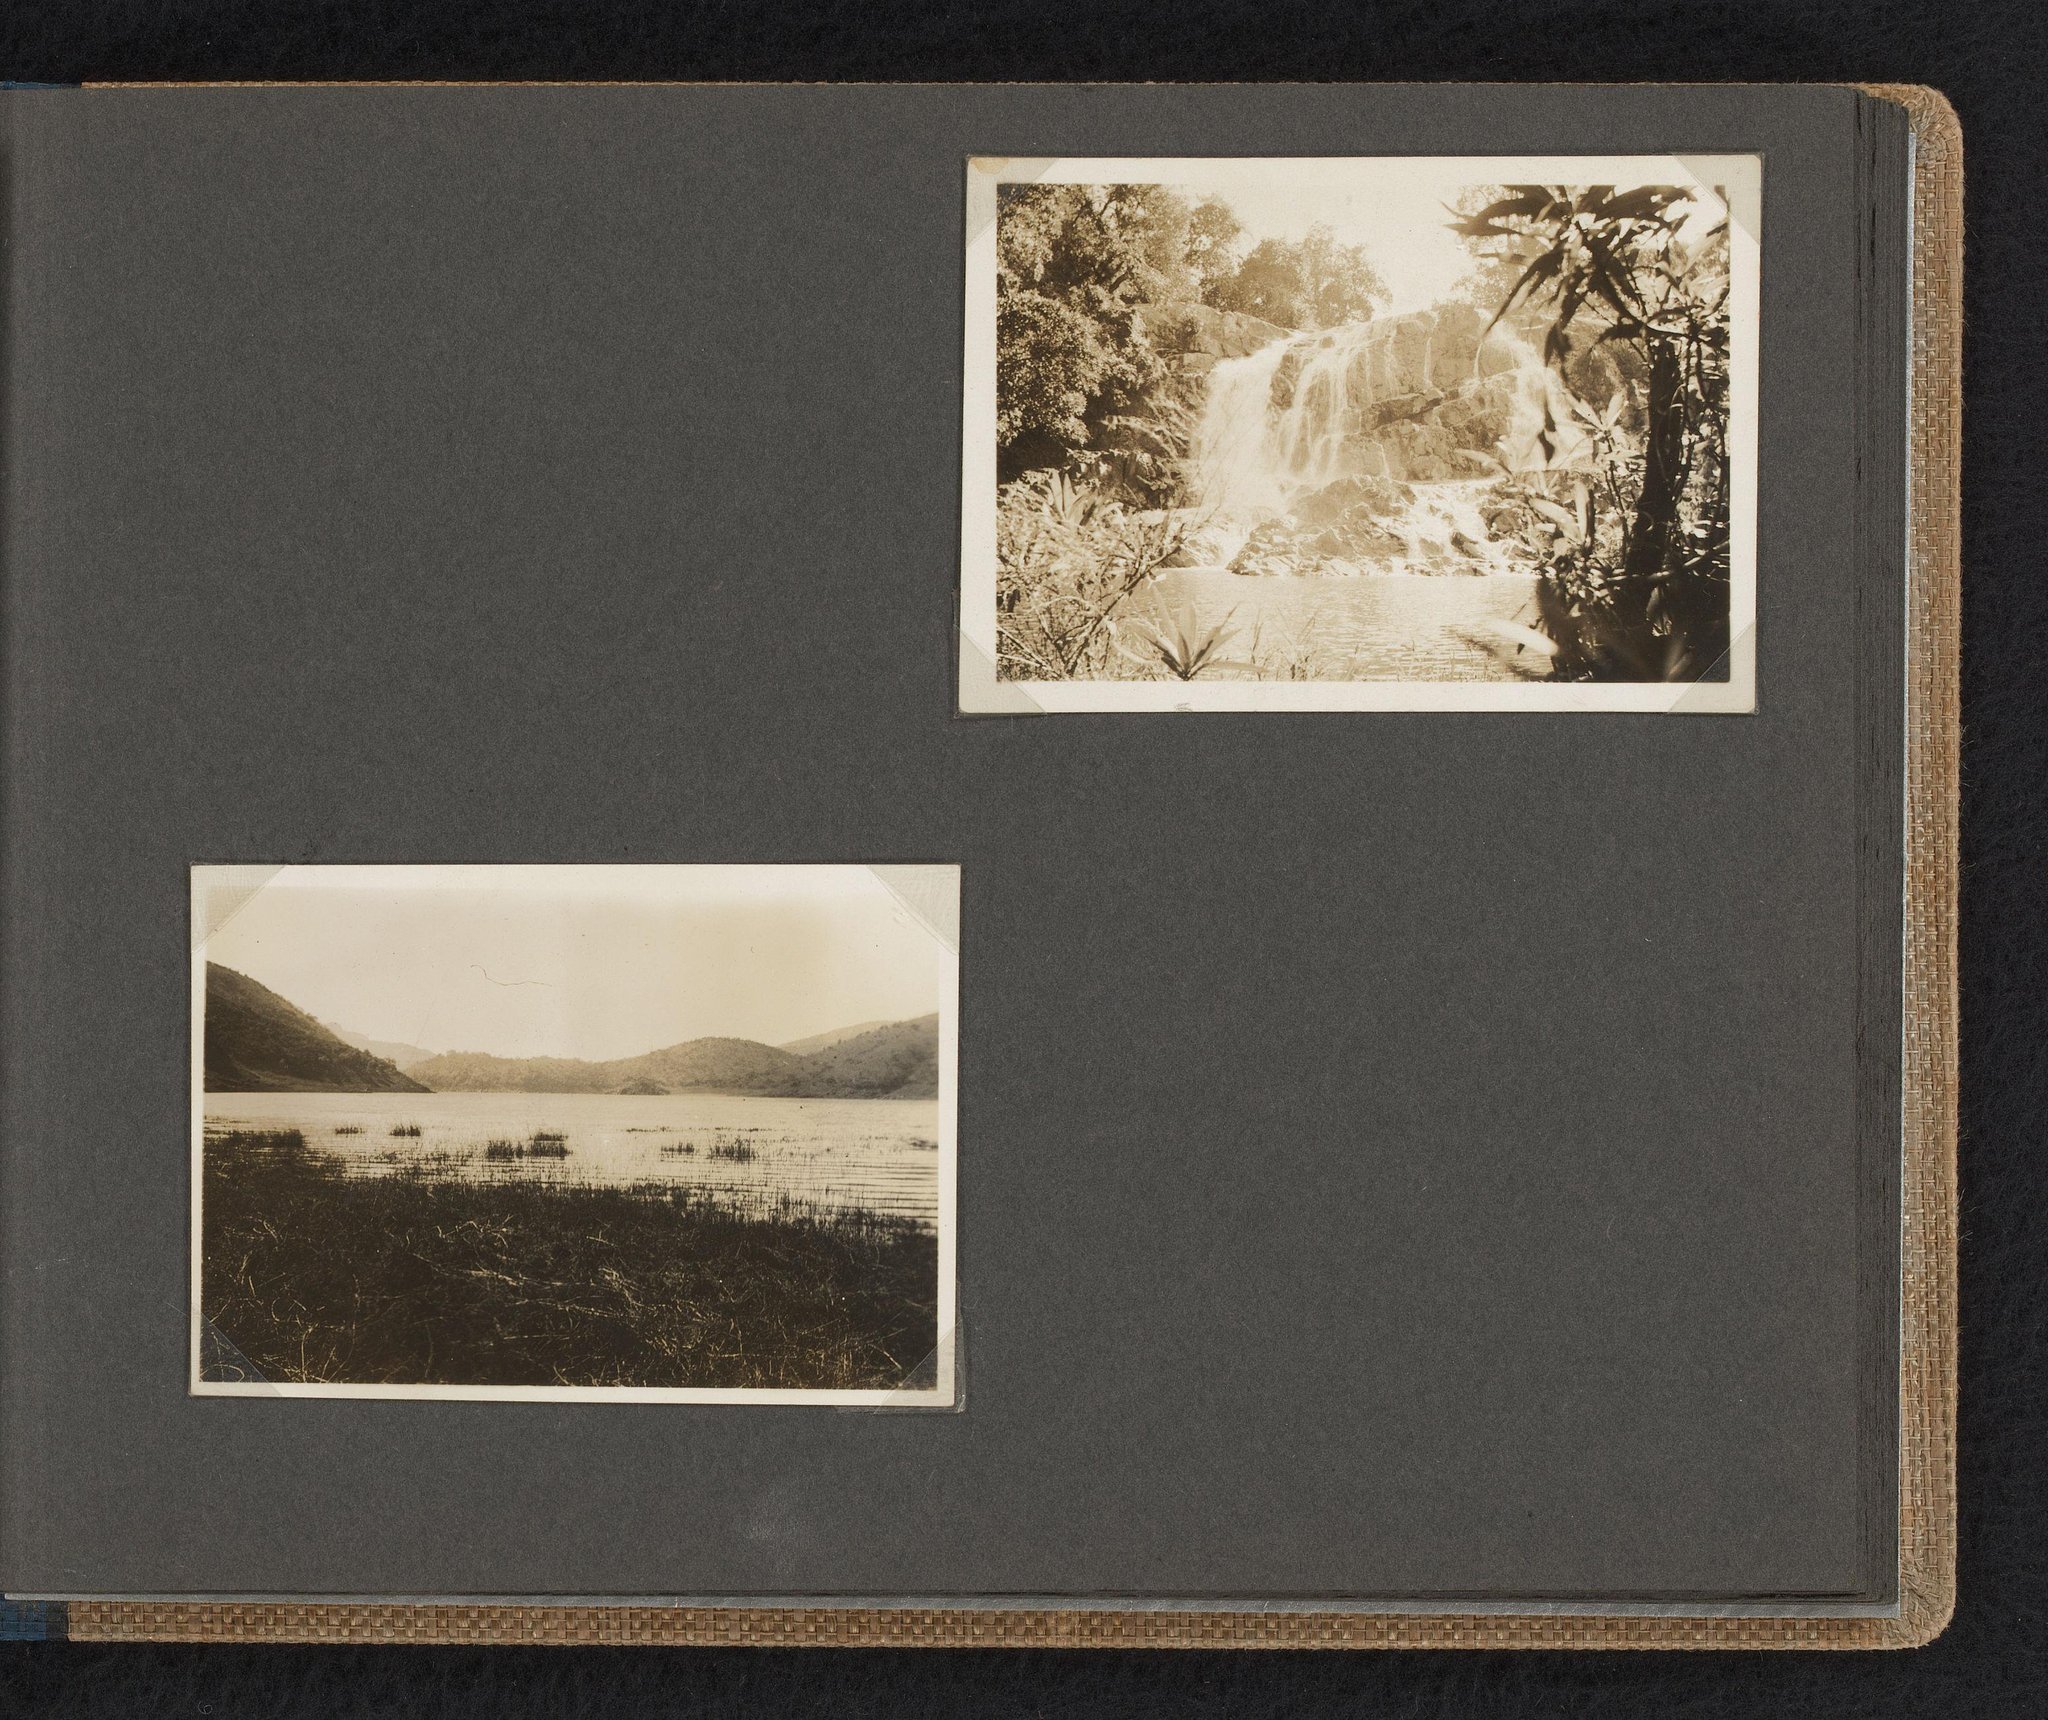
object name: photograph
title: Waterval en bergmeer, in Zuid-Afrika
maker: karel frederik van den berg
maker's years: 1873-1948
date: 1920-1930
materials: paper, cardboard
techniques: gelatin silver print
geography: south africa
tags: waterfall, lake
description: Deze foto's zijn onderdeel van een album.